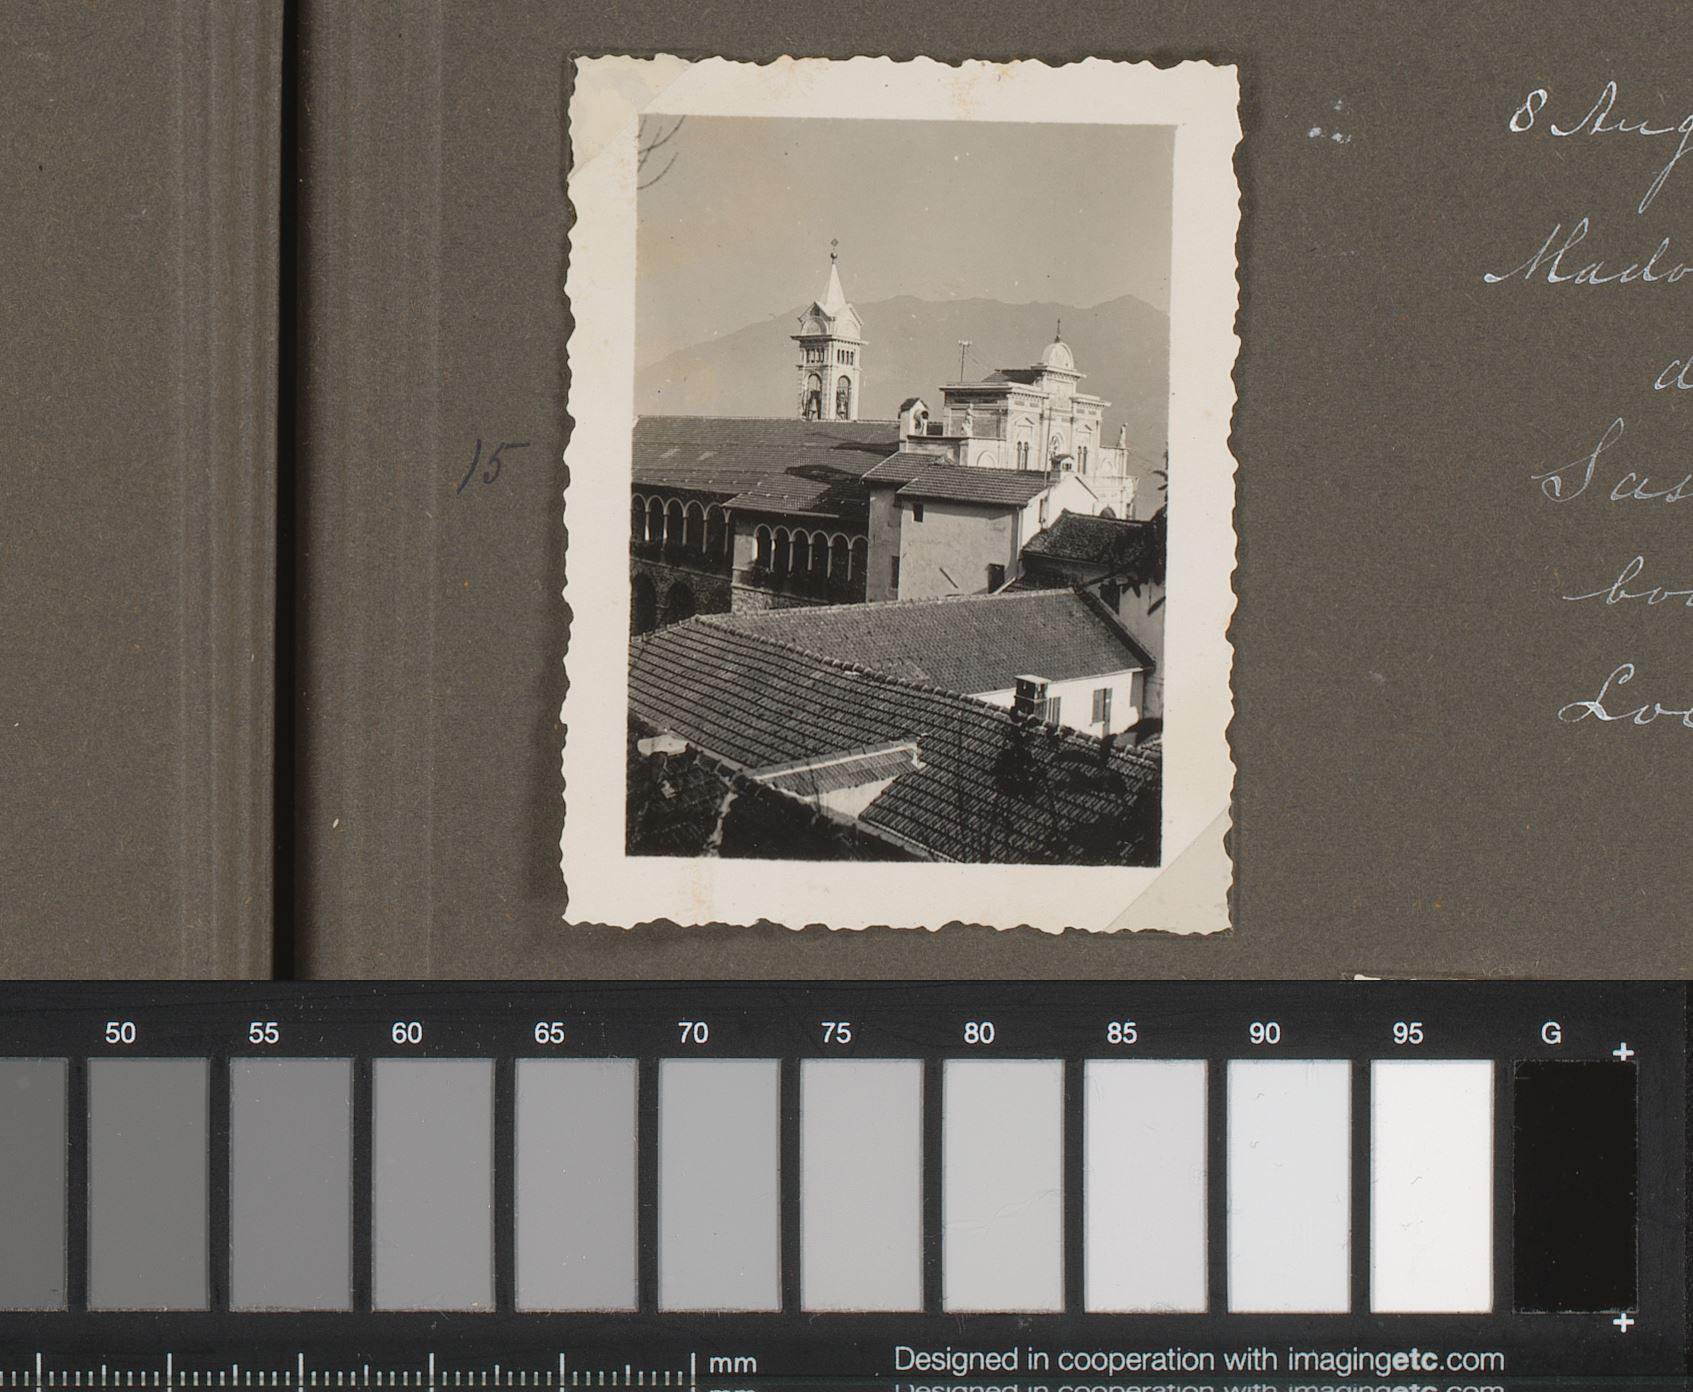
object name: photograph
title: Madonna del Sasso boven Locarno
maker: Anonymous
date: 1934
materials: photographic support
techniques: gelatin silver print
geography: locarno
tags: place of pilgrimage, sacred place, abbey, monastery, convent ~ roman catholic church, church (exterior)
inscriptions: number: ‘15’